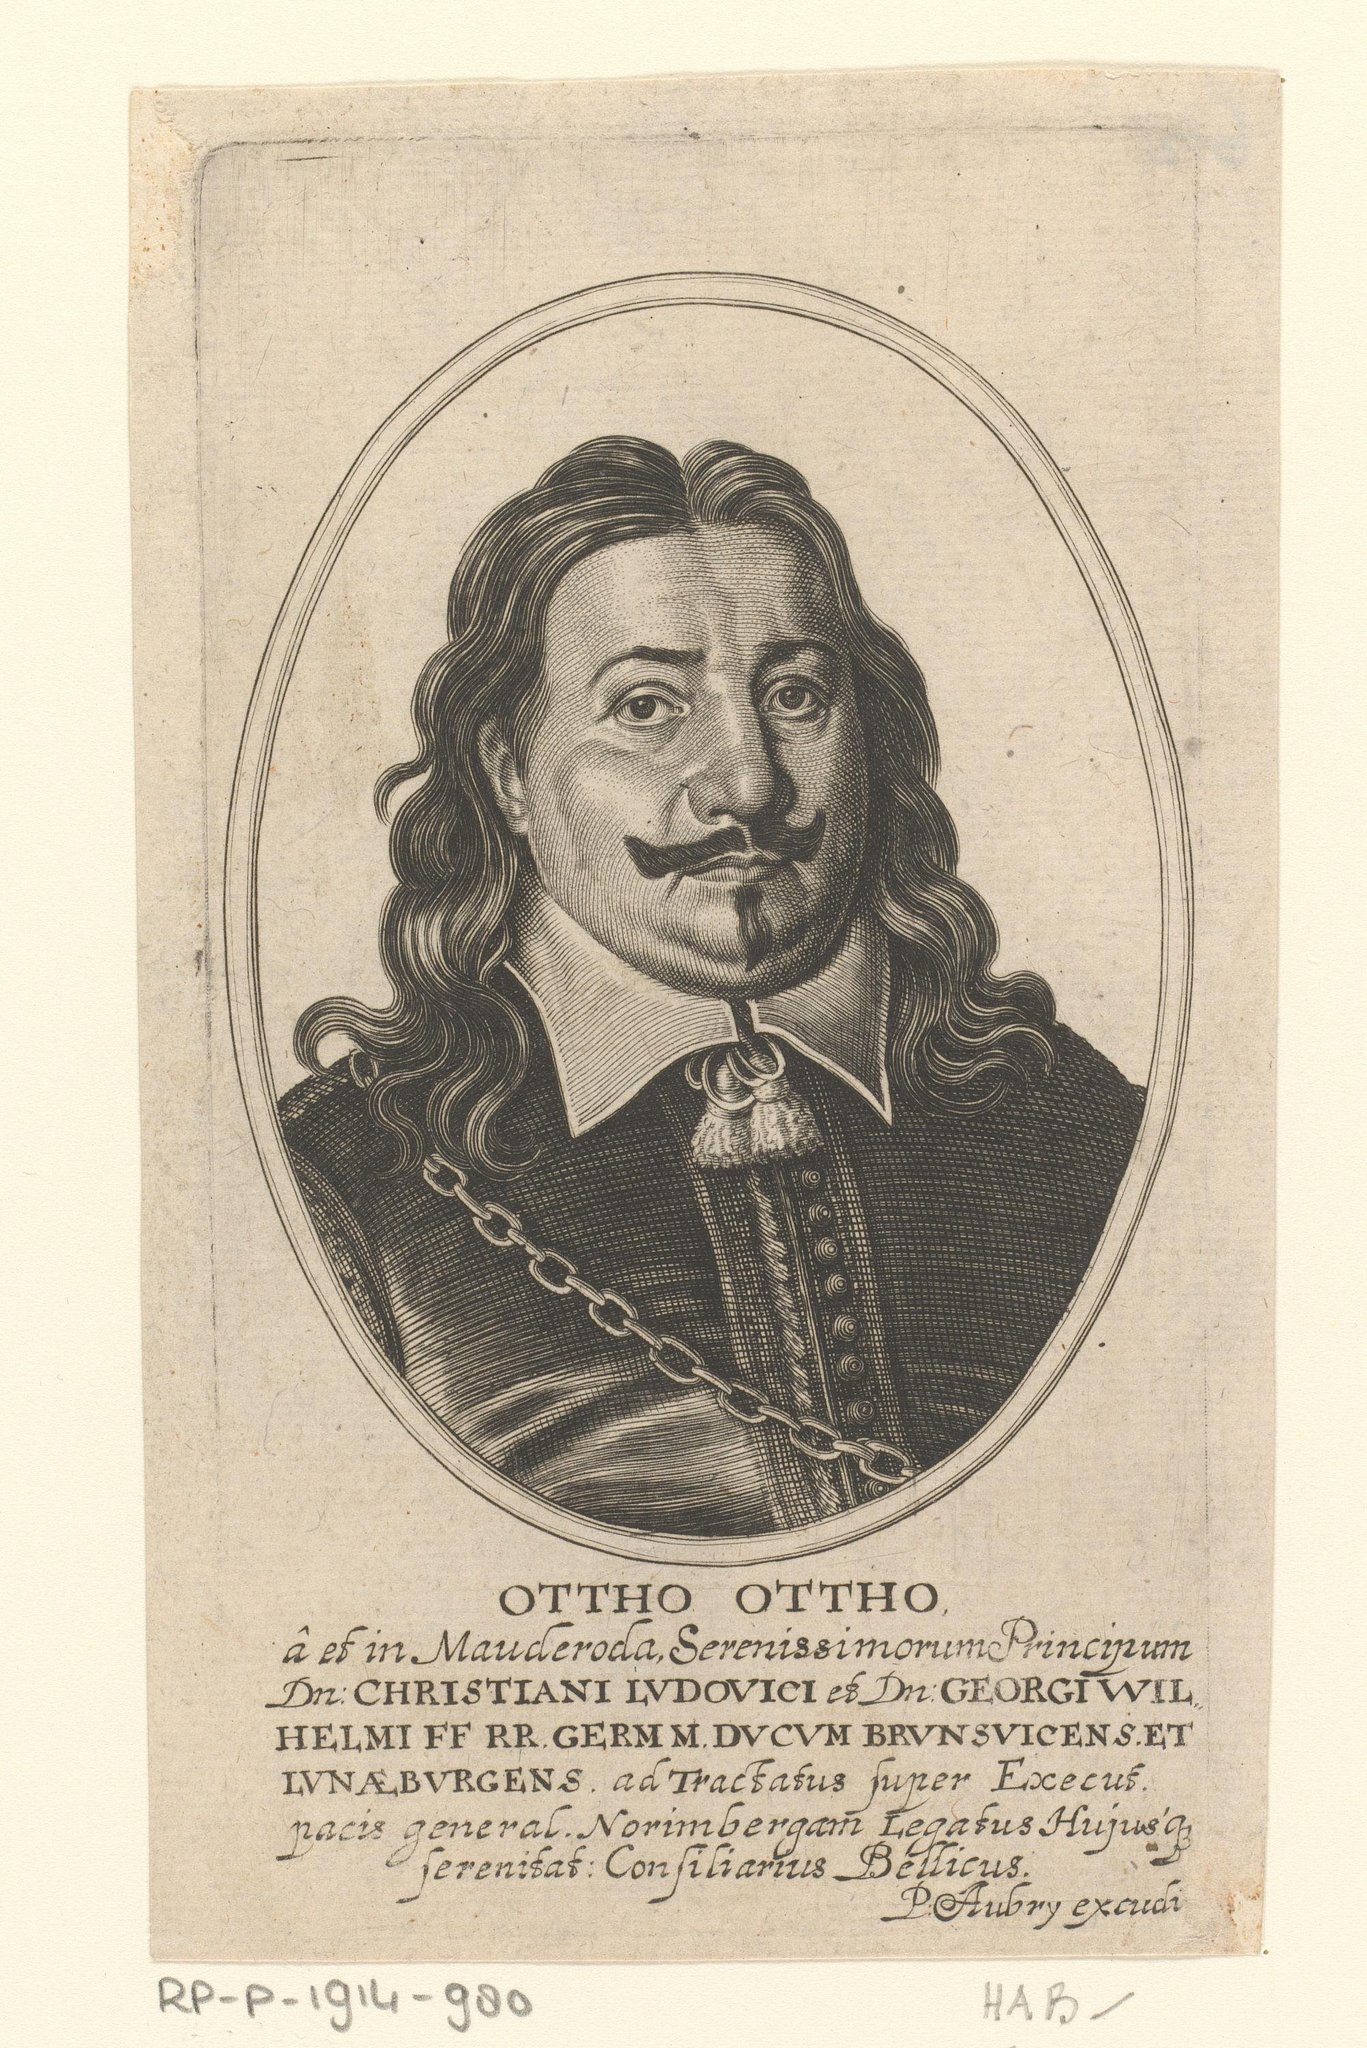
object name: print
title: Portret van Otto Otto von Mauderode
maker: Anonymous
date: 1640-1686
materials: paper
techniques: engraving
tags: minister ~ government, historical persons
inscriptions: collector's mark: Lugt 2228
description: Met zesregelig onderschrift in het Latijn.